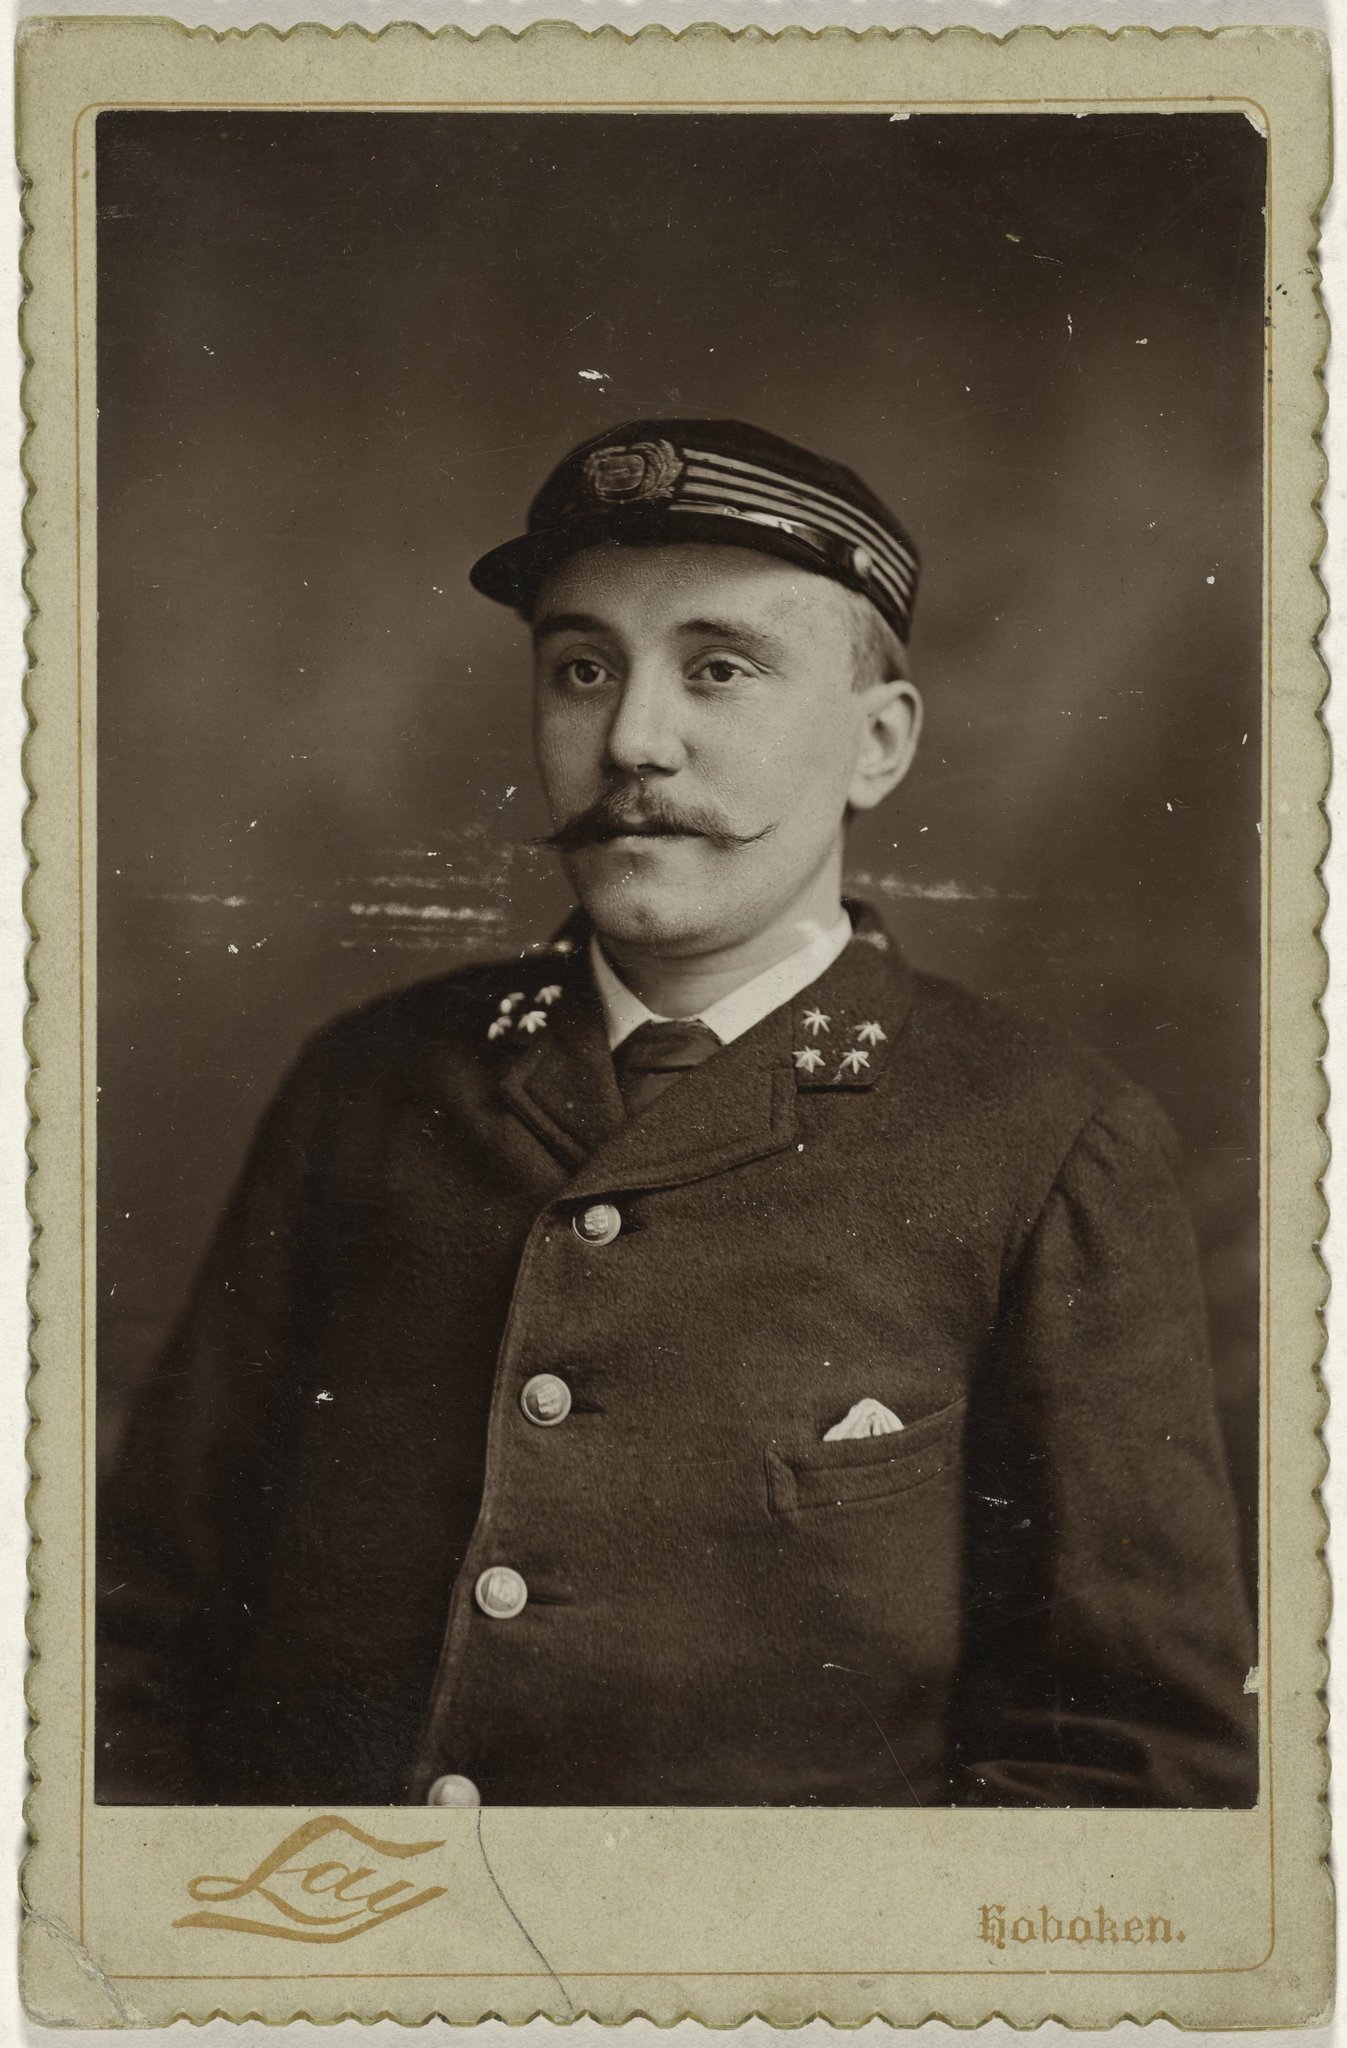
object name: cabinet photograph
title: Portret van een onbekende man, mogelijk een militair of een conducteur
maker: herman norton lay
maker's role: fotograaf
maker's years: 1847-1895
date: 1884-1895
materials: paper, cardboard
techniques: collodion silver print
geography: hoboken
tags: historical persons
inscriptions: address: ‘252 Washington St./ Hoboken N.J.’